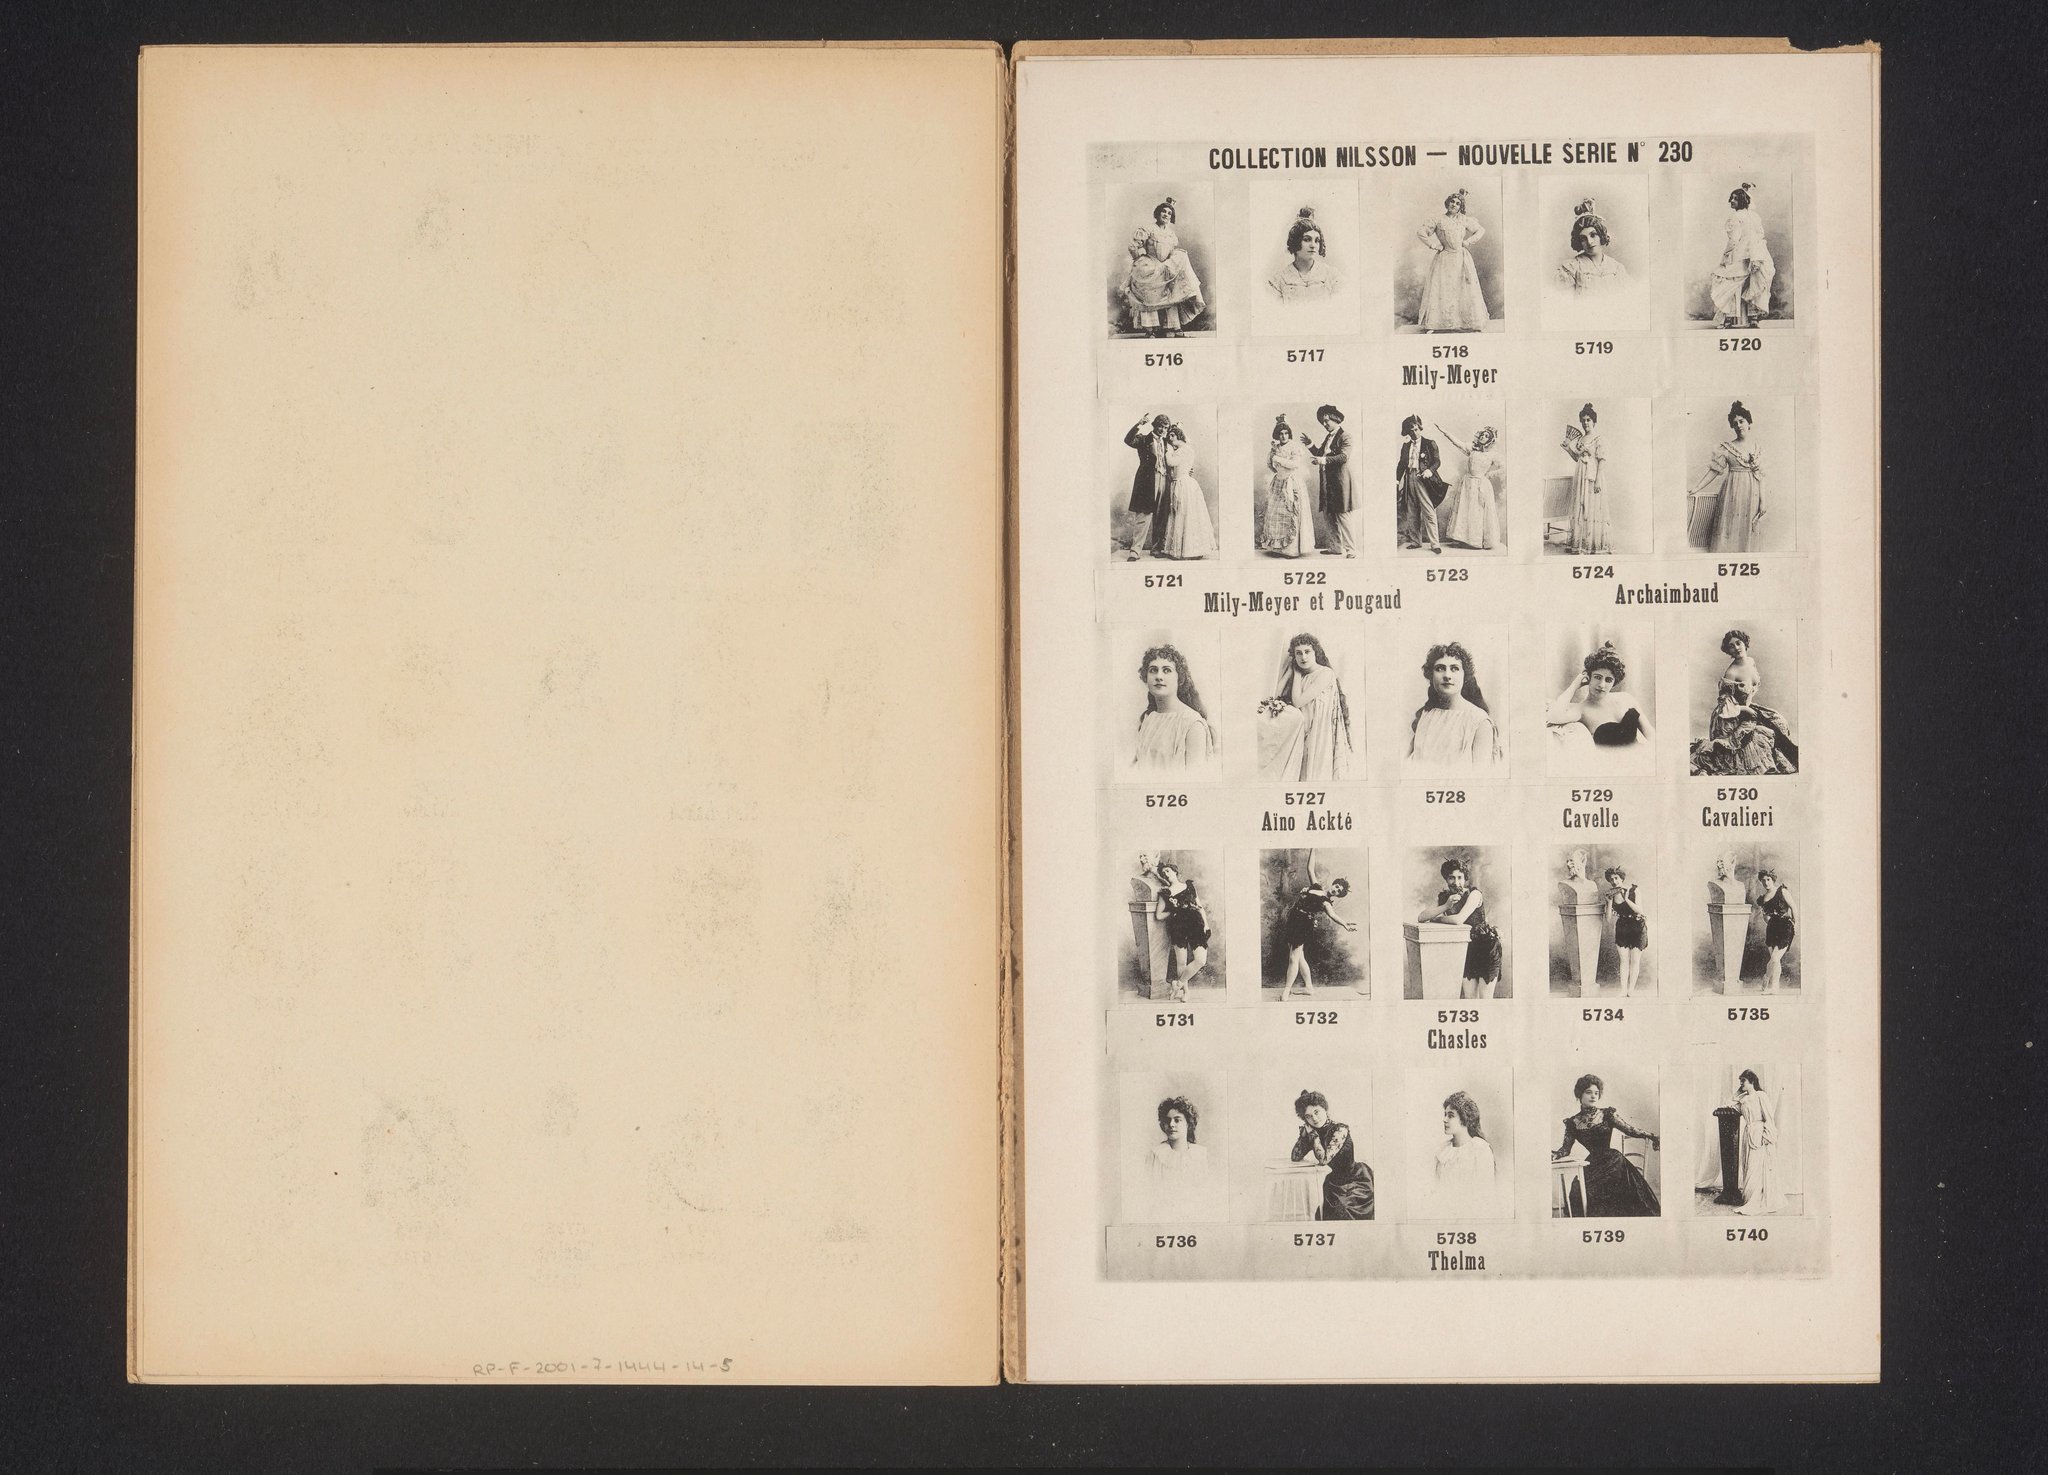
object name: page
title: Collection Nilsson - Nouvelle Série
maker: Anonymous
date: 1894-1899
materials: paper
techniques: photograph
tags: historical persons - bb - woman, portrait of opera-singer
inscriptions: number: ‘No 230’